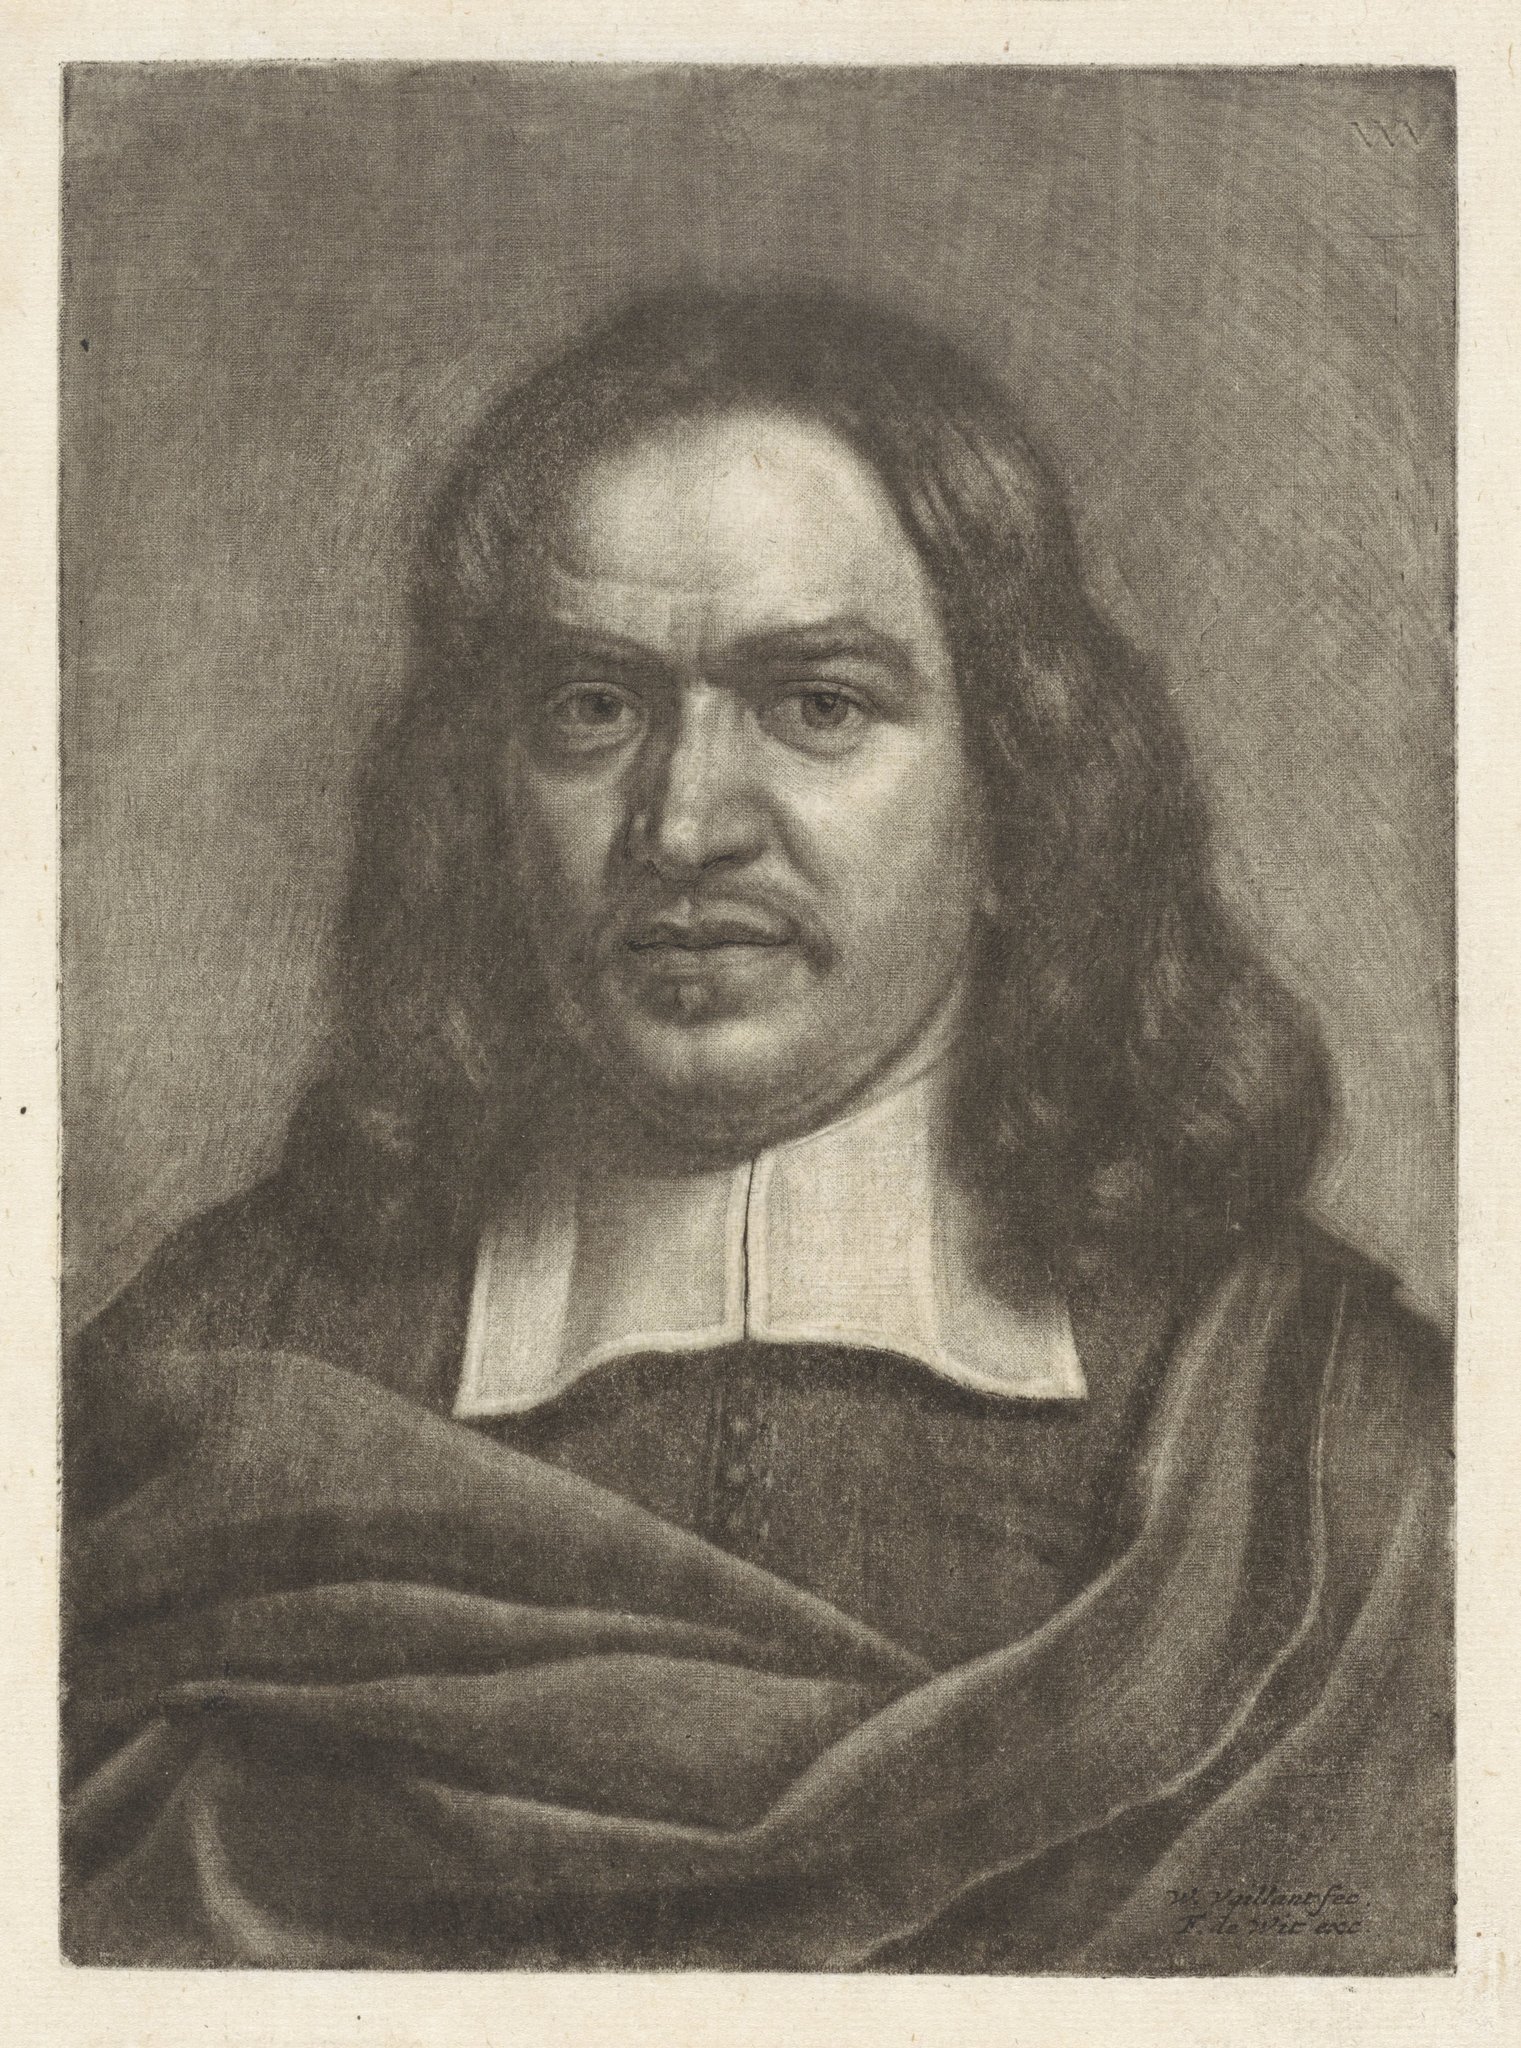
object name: print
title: Portret van een man, van voren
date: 1658-1706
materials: paper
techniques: mezzotint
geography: amsterdam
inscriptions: collector's mark: Lugt 2228